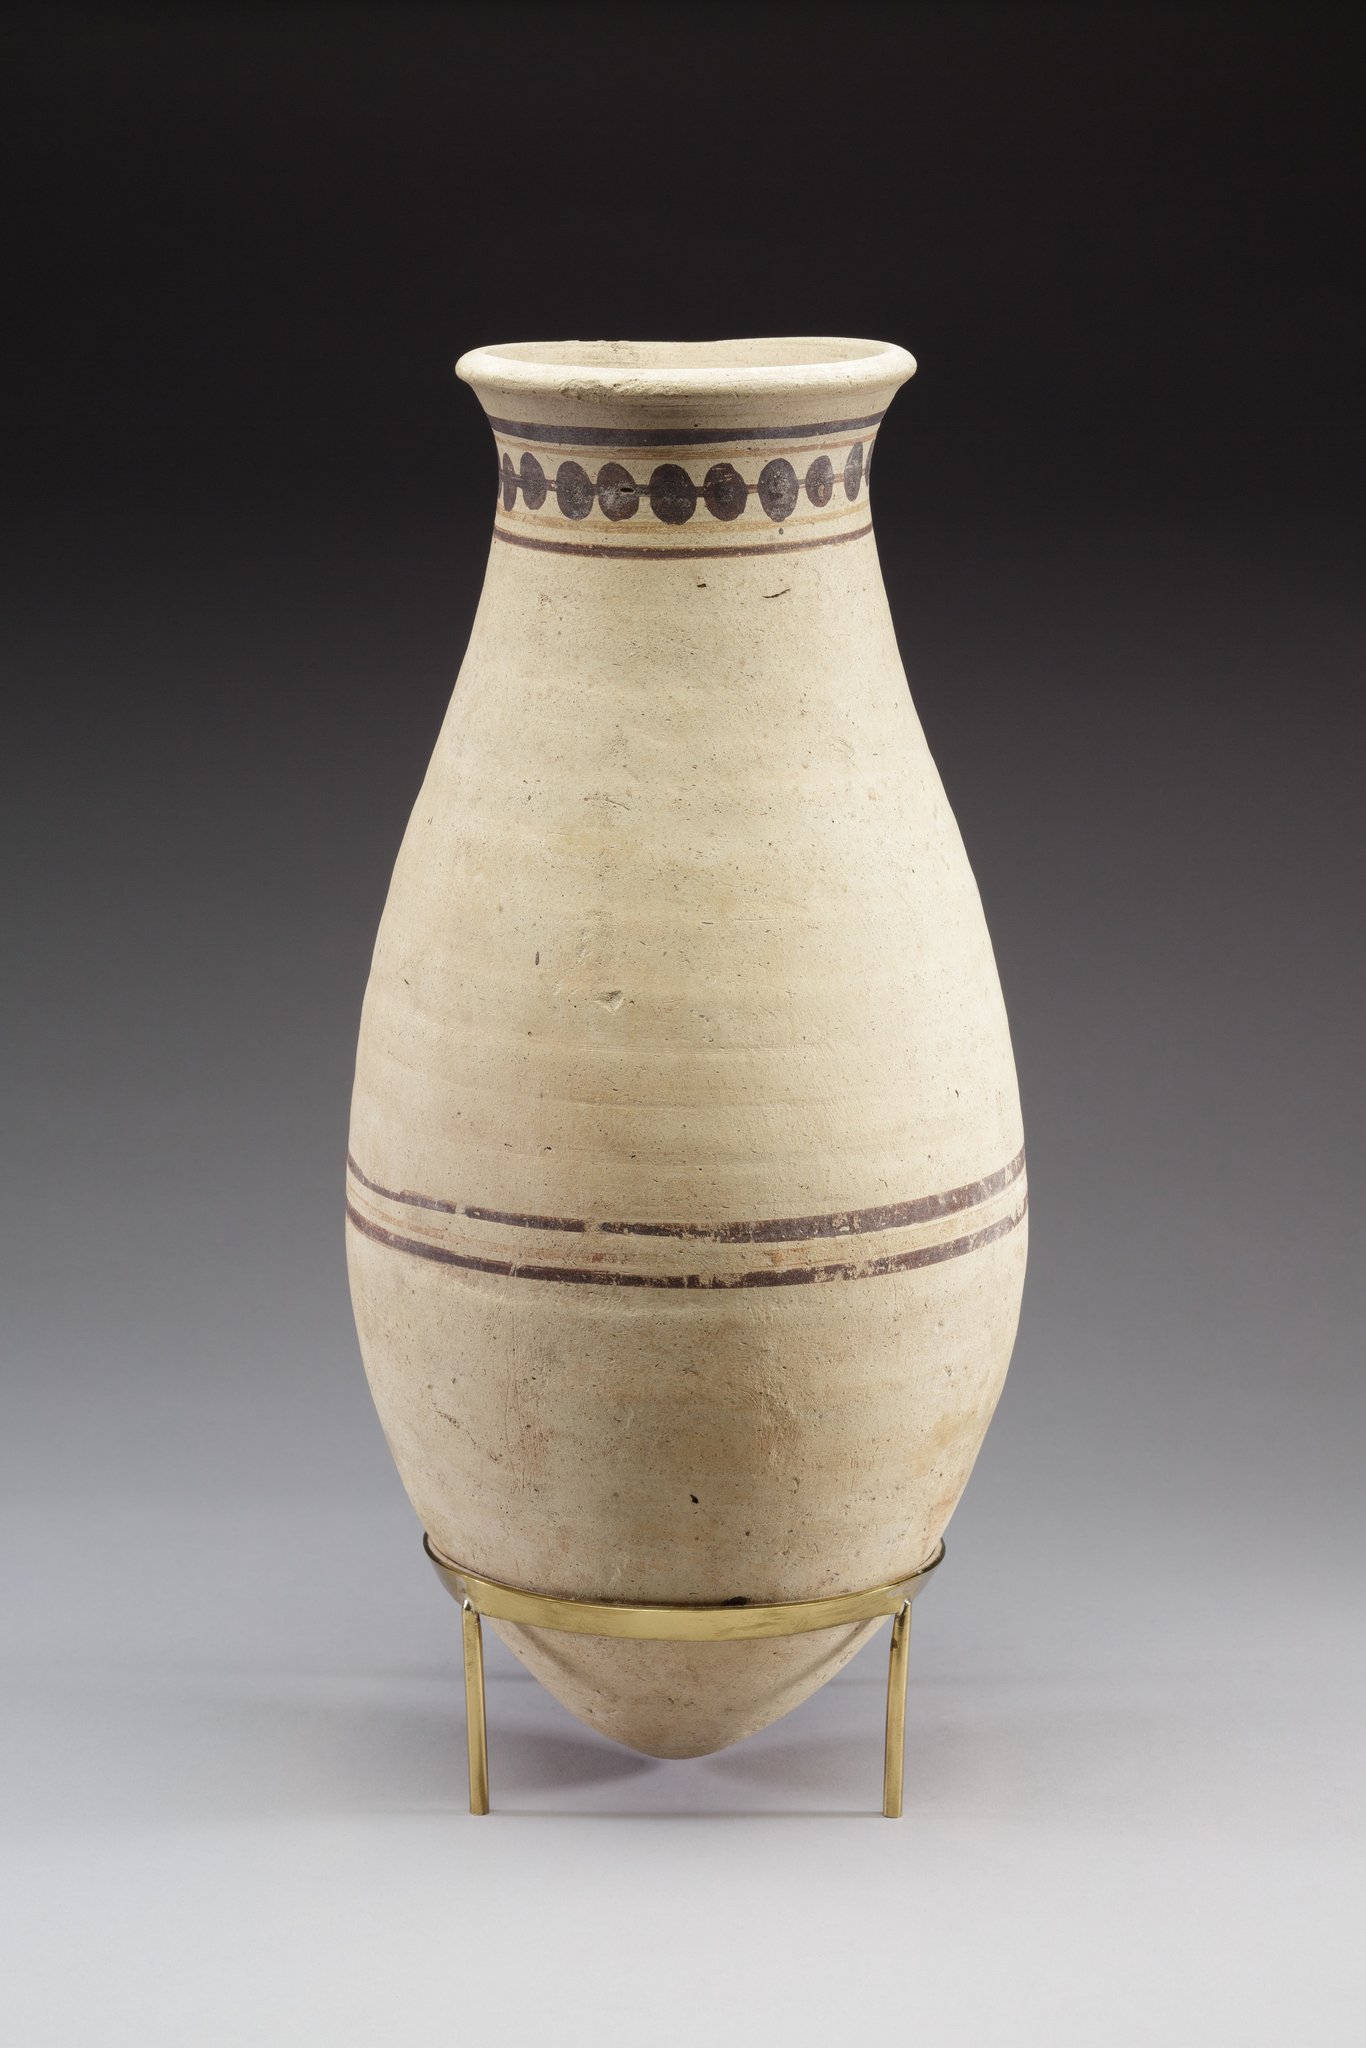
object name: jar, marl, amenhotep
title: Jar from the Burial of Amenhotep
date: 1479-1458 BCE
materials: paint, pottery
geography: egypt